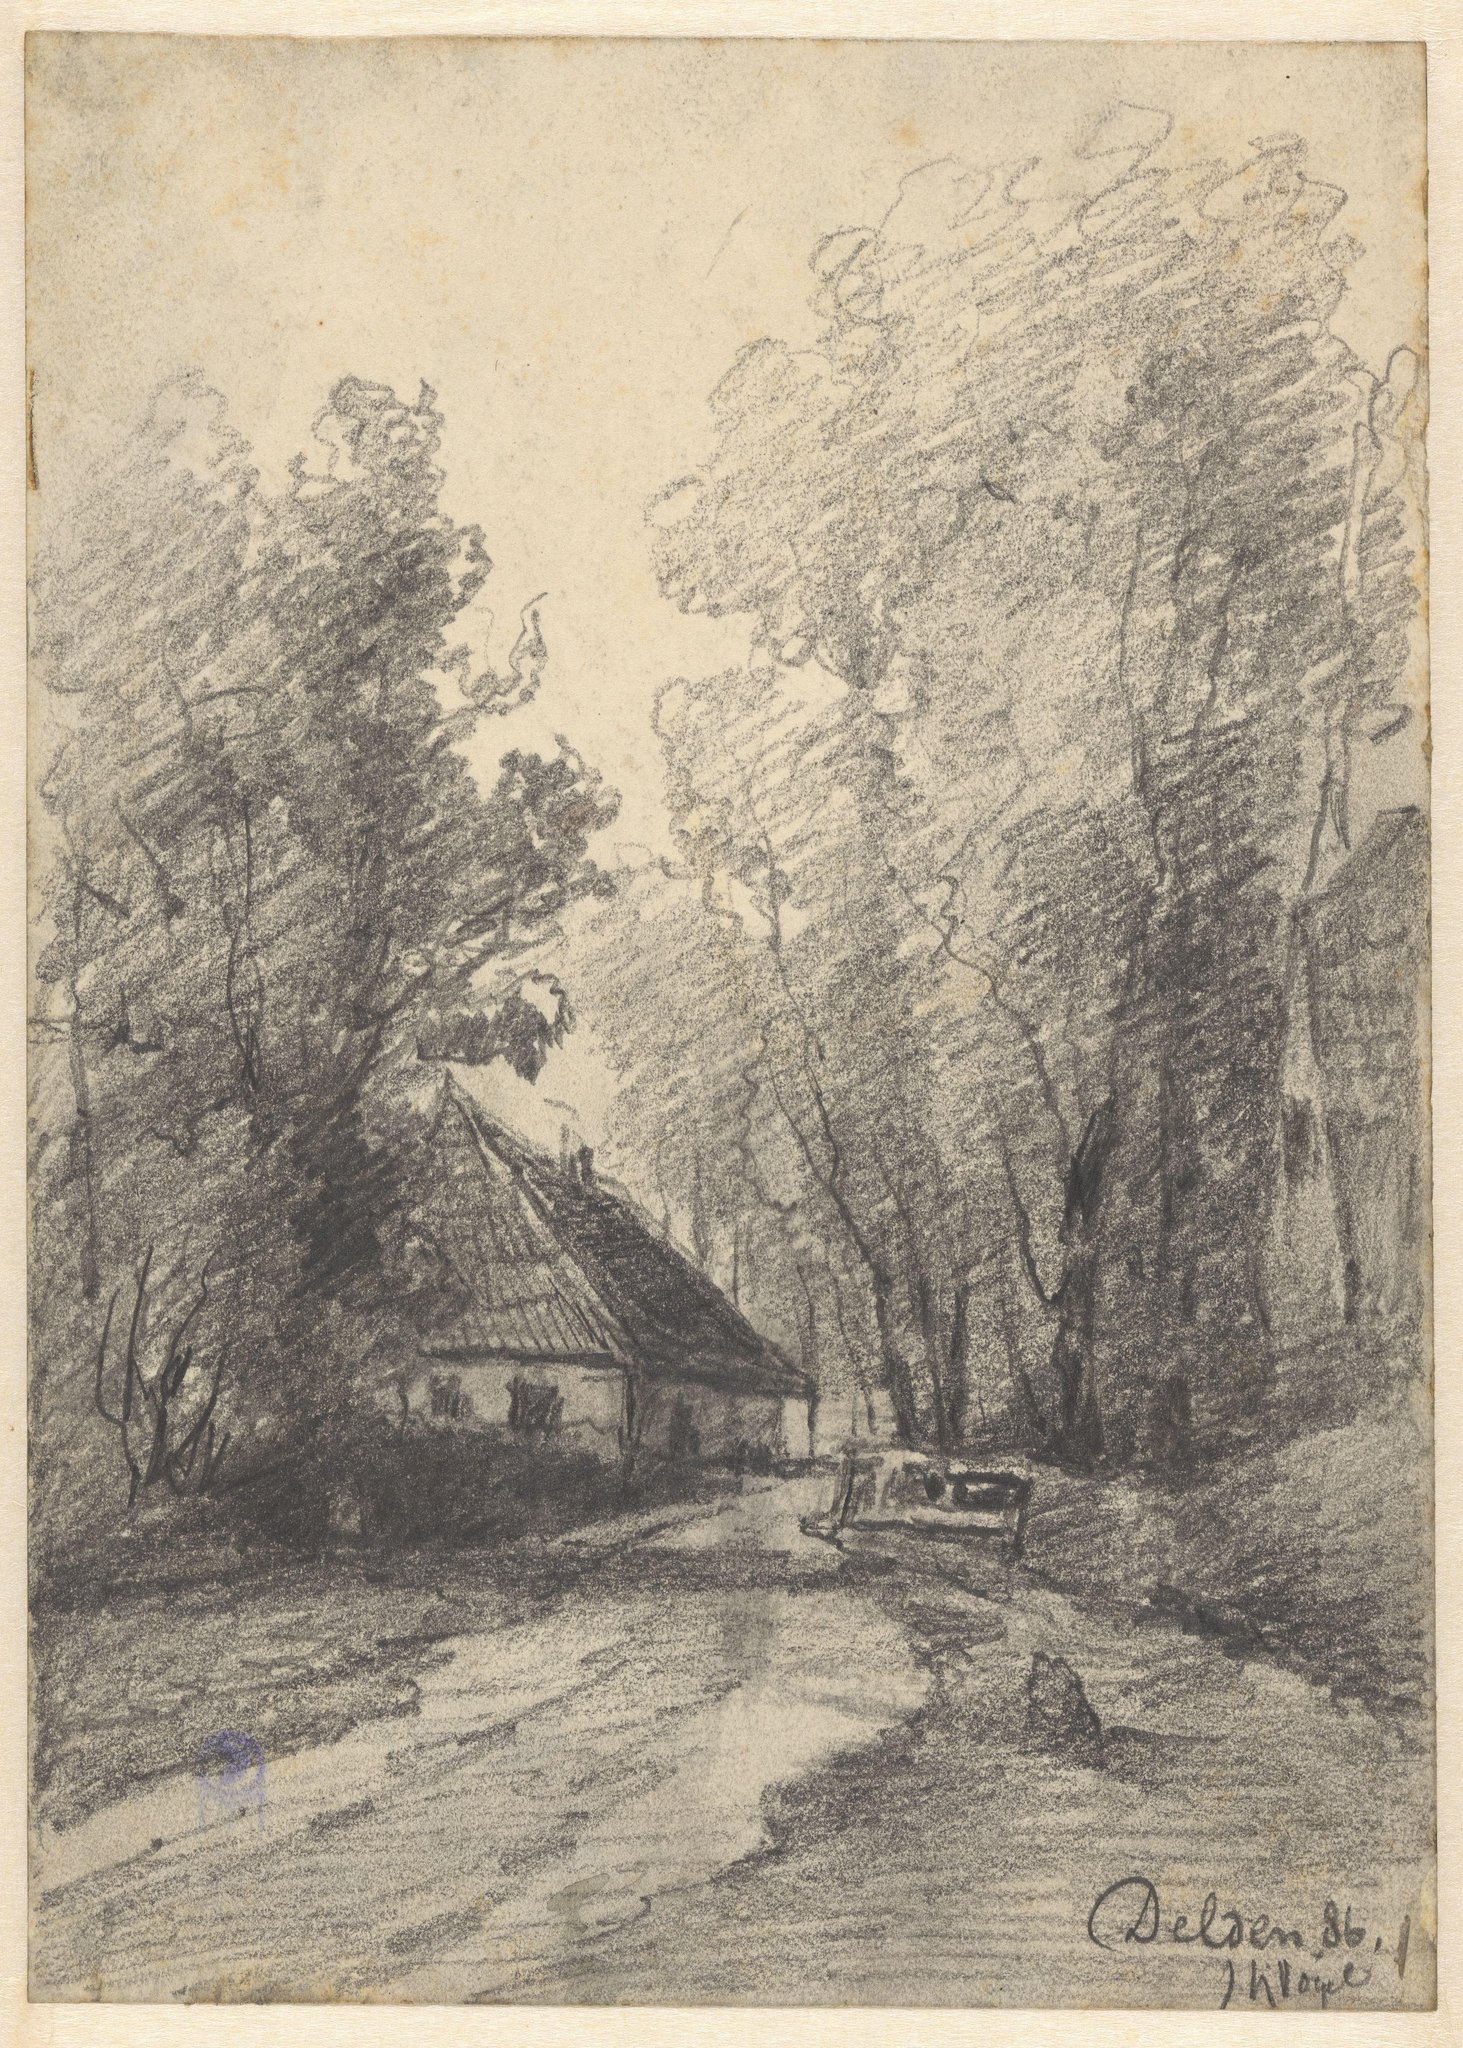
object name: drawing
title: Huis langs een weg te Delden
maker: johannes gijsbert vogel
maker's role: draughtsman, painter, print maker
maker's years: 1828-1915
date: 1886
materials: paper, pencil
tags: farm or solitary house in landscape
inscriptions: collector's mark: Lugt 1181b, date and inscription: ‘Delden 86.’